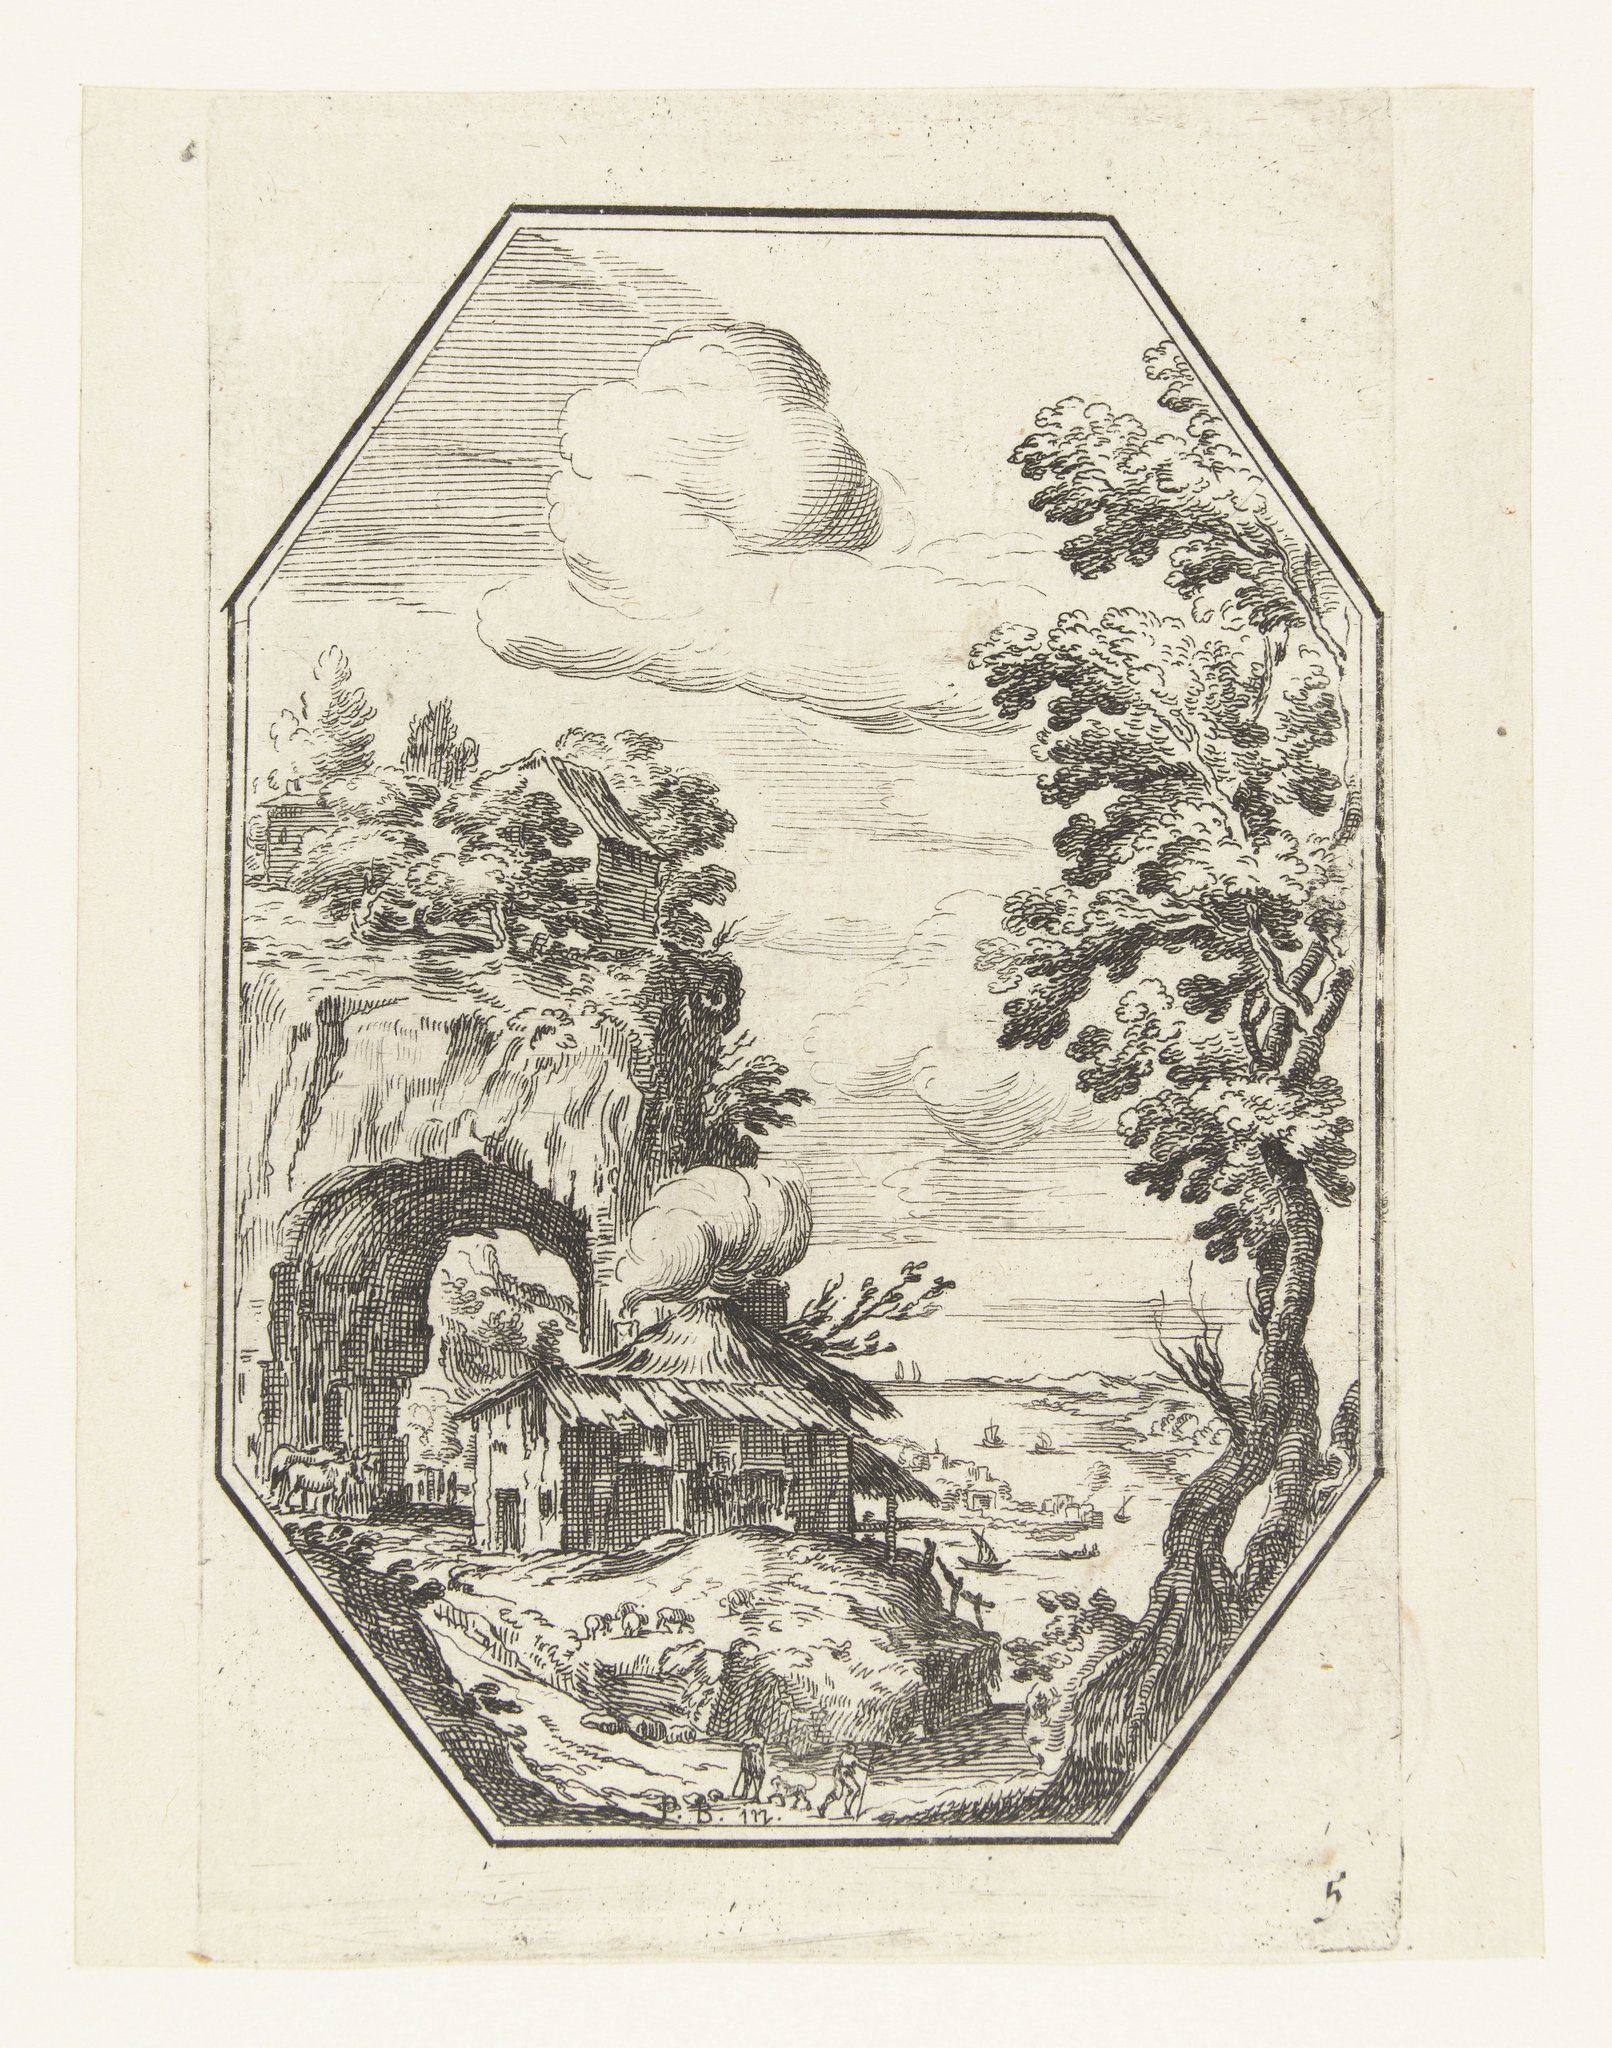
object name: print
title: Landschap met boerderij in octagonaal kader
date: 1582-1700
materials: paper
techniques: etching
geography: rome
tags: farm or solitary house in landscape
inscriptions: collector's mark: Lugt 240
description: Landschap met boerderij in octagonaal kader, kopie naar prent van Paul Bril met landschap spiegelverkeerd weergegeven.